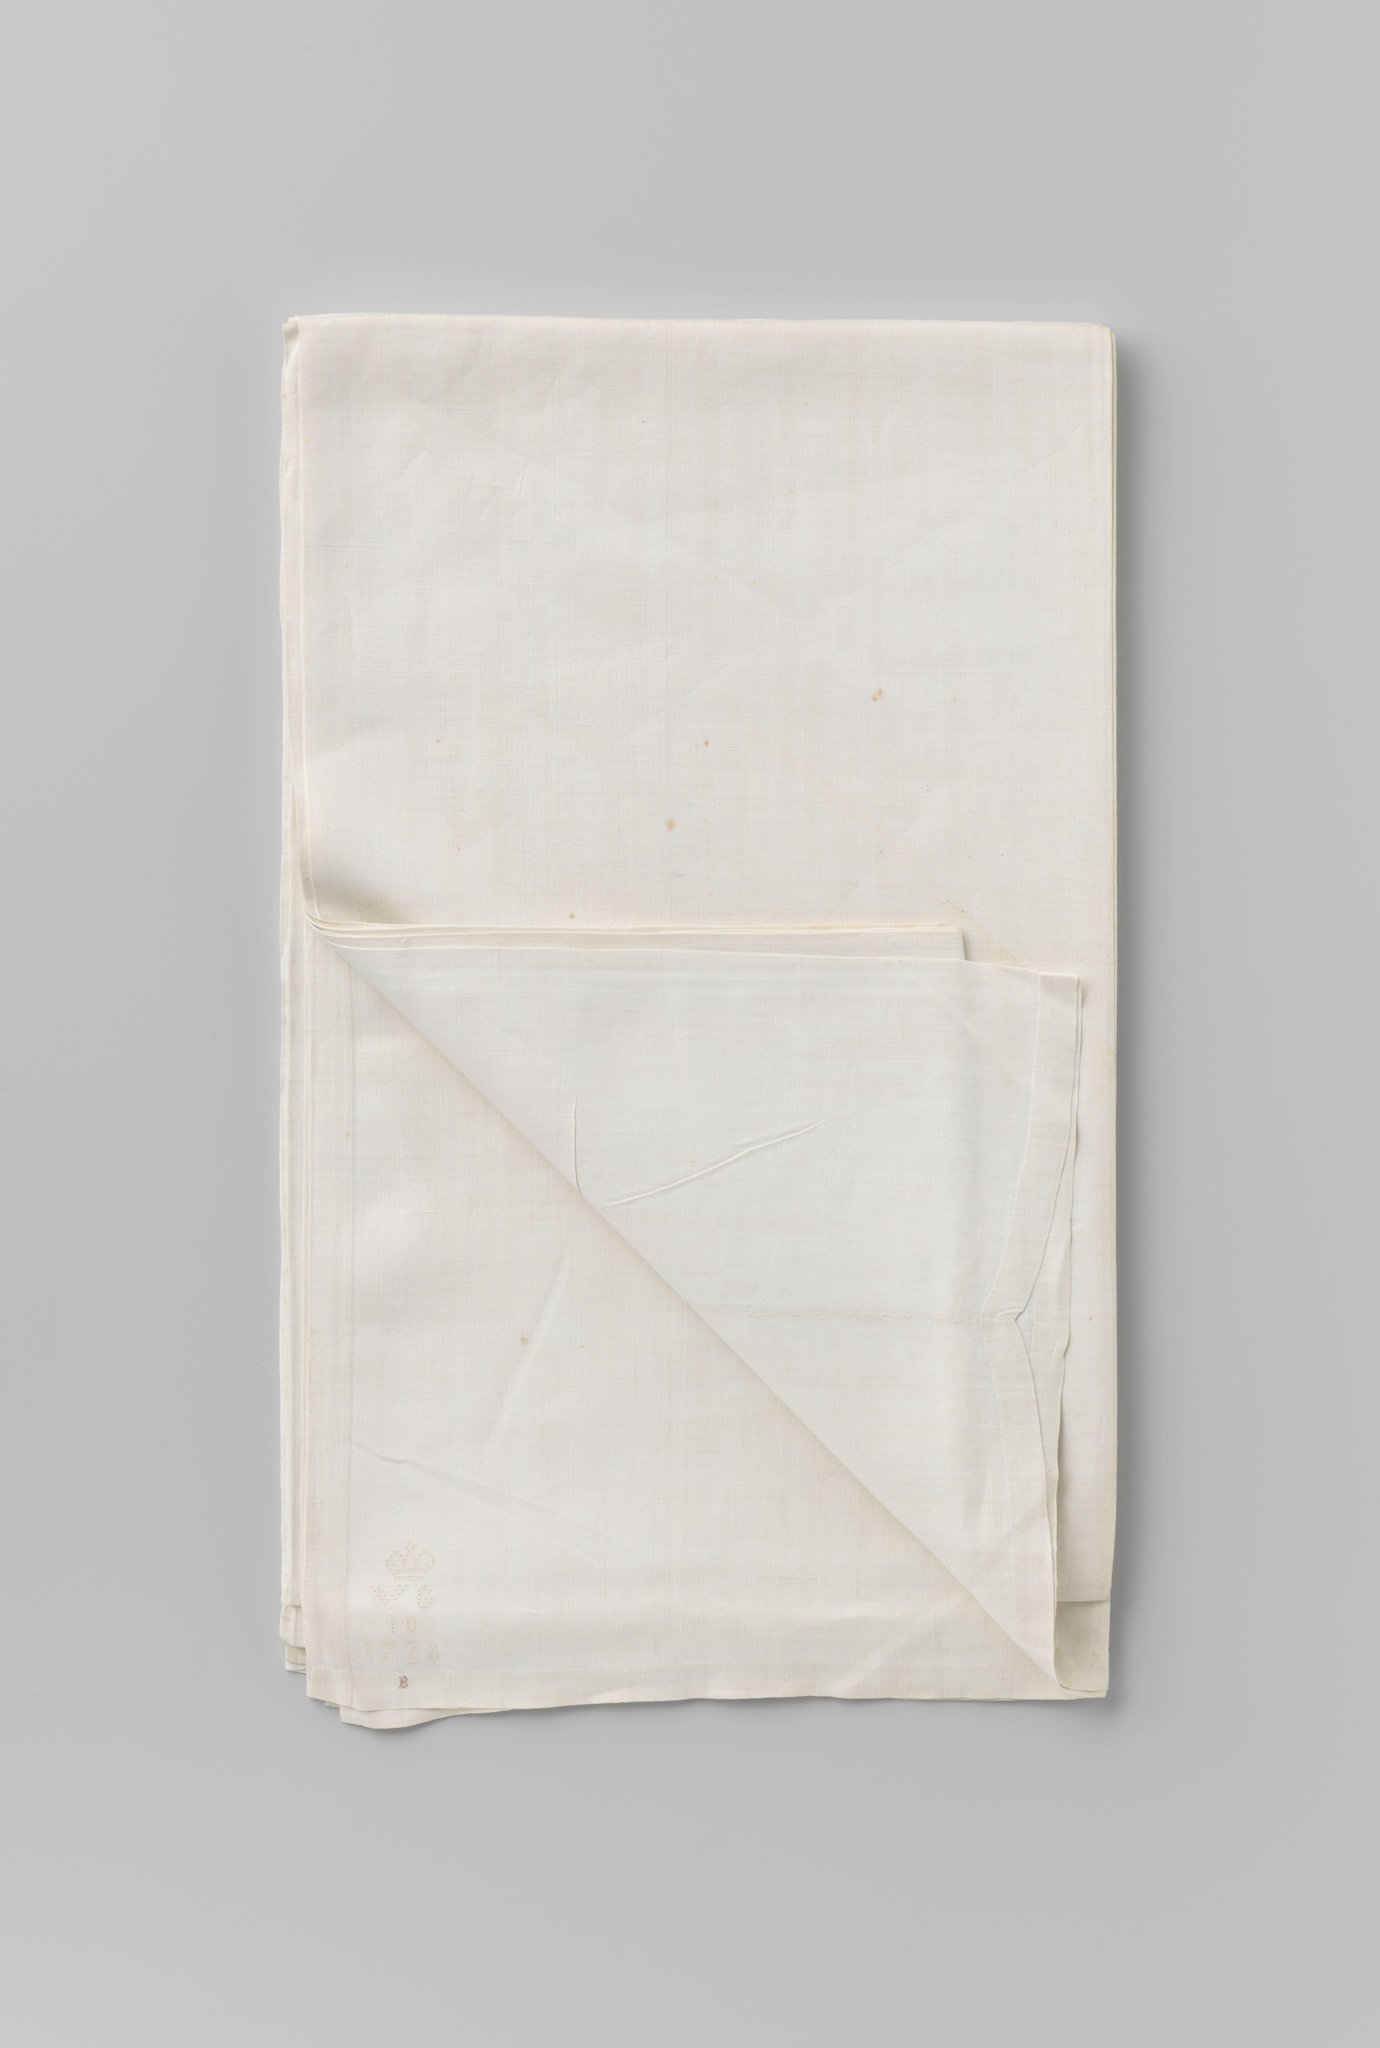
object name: beddenlaken, laken object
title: Laken. Merk: kroon WG10 en jaartal 1738 en B.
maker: Anonymous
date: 1725-1786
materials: linen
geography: northern netherlands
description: Laken van wit linnen, merk kroon WG 10 en jaartal 1738 en B